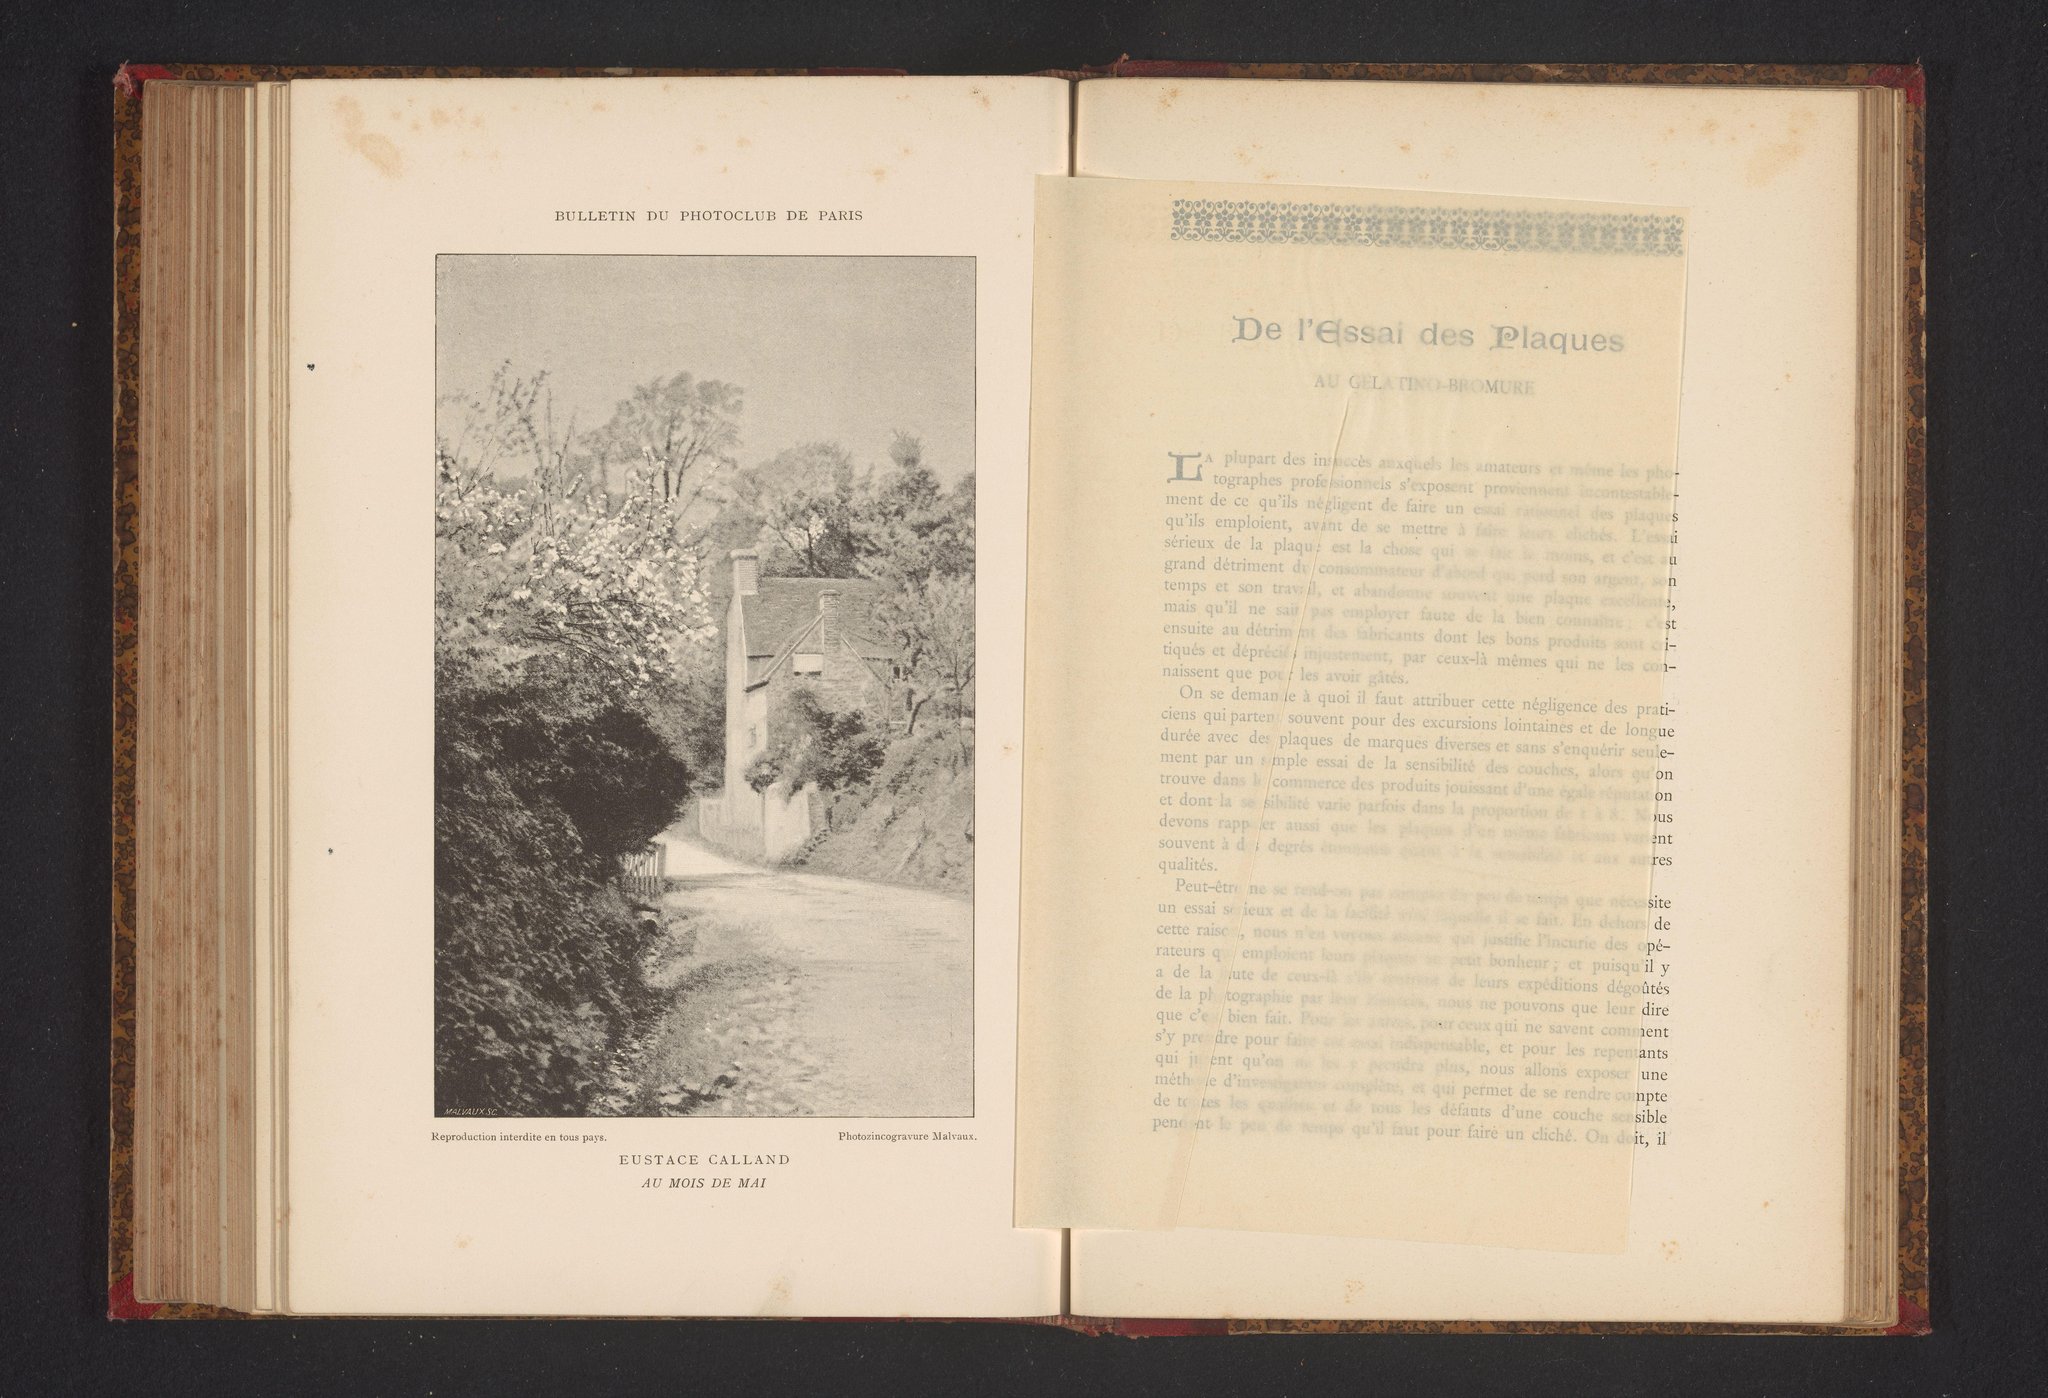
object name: page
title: Gezicht op de zijkant van een huis aan een landweg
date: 1888-1893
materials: paper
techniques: autotype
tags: rural housing, e.g. country-house, villa, cottage, road, path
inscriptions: inscription: ‘Reproduction interdite en tous pays.’, inscription: ‘Bulletin du Photoclub de Paris’